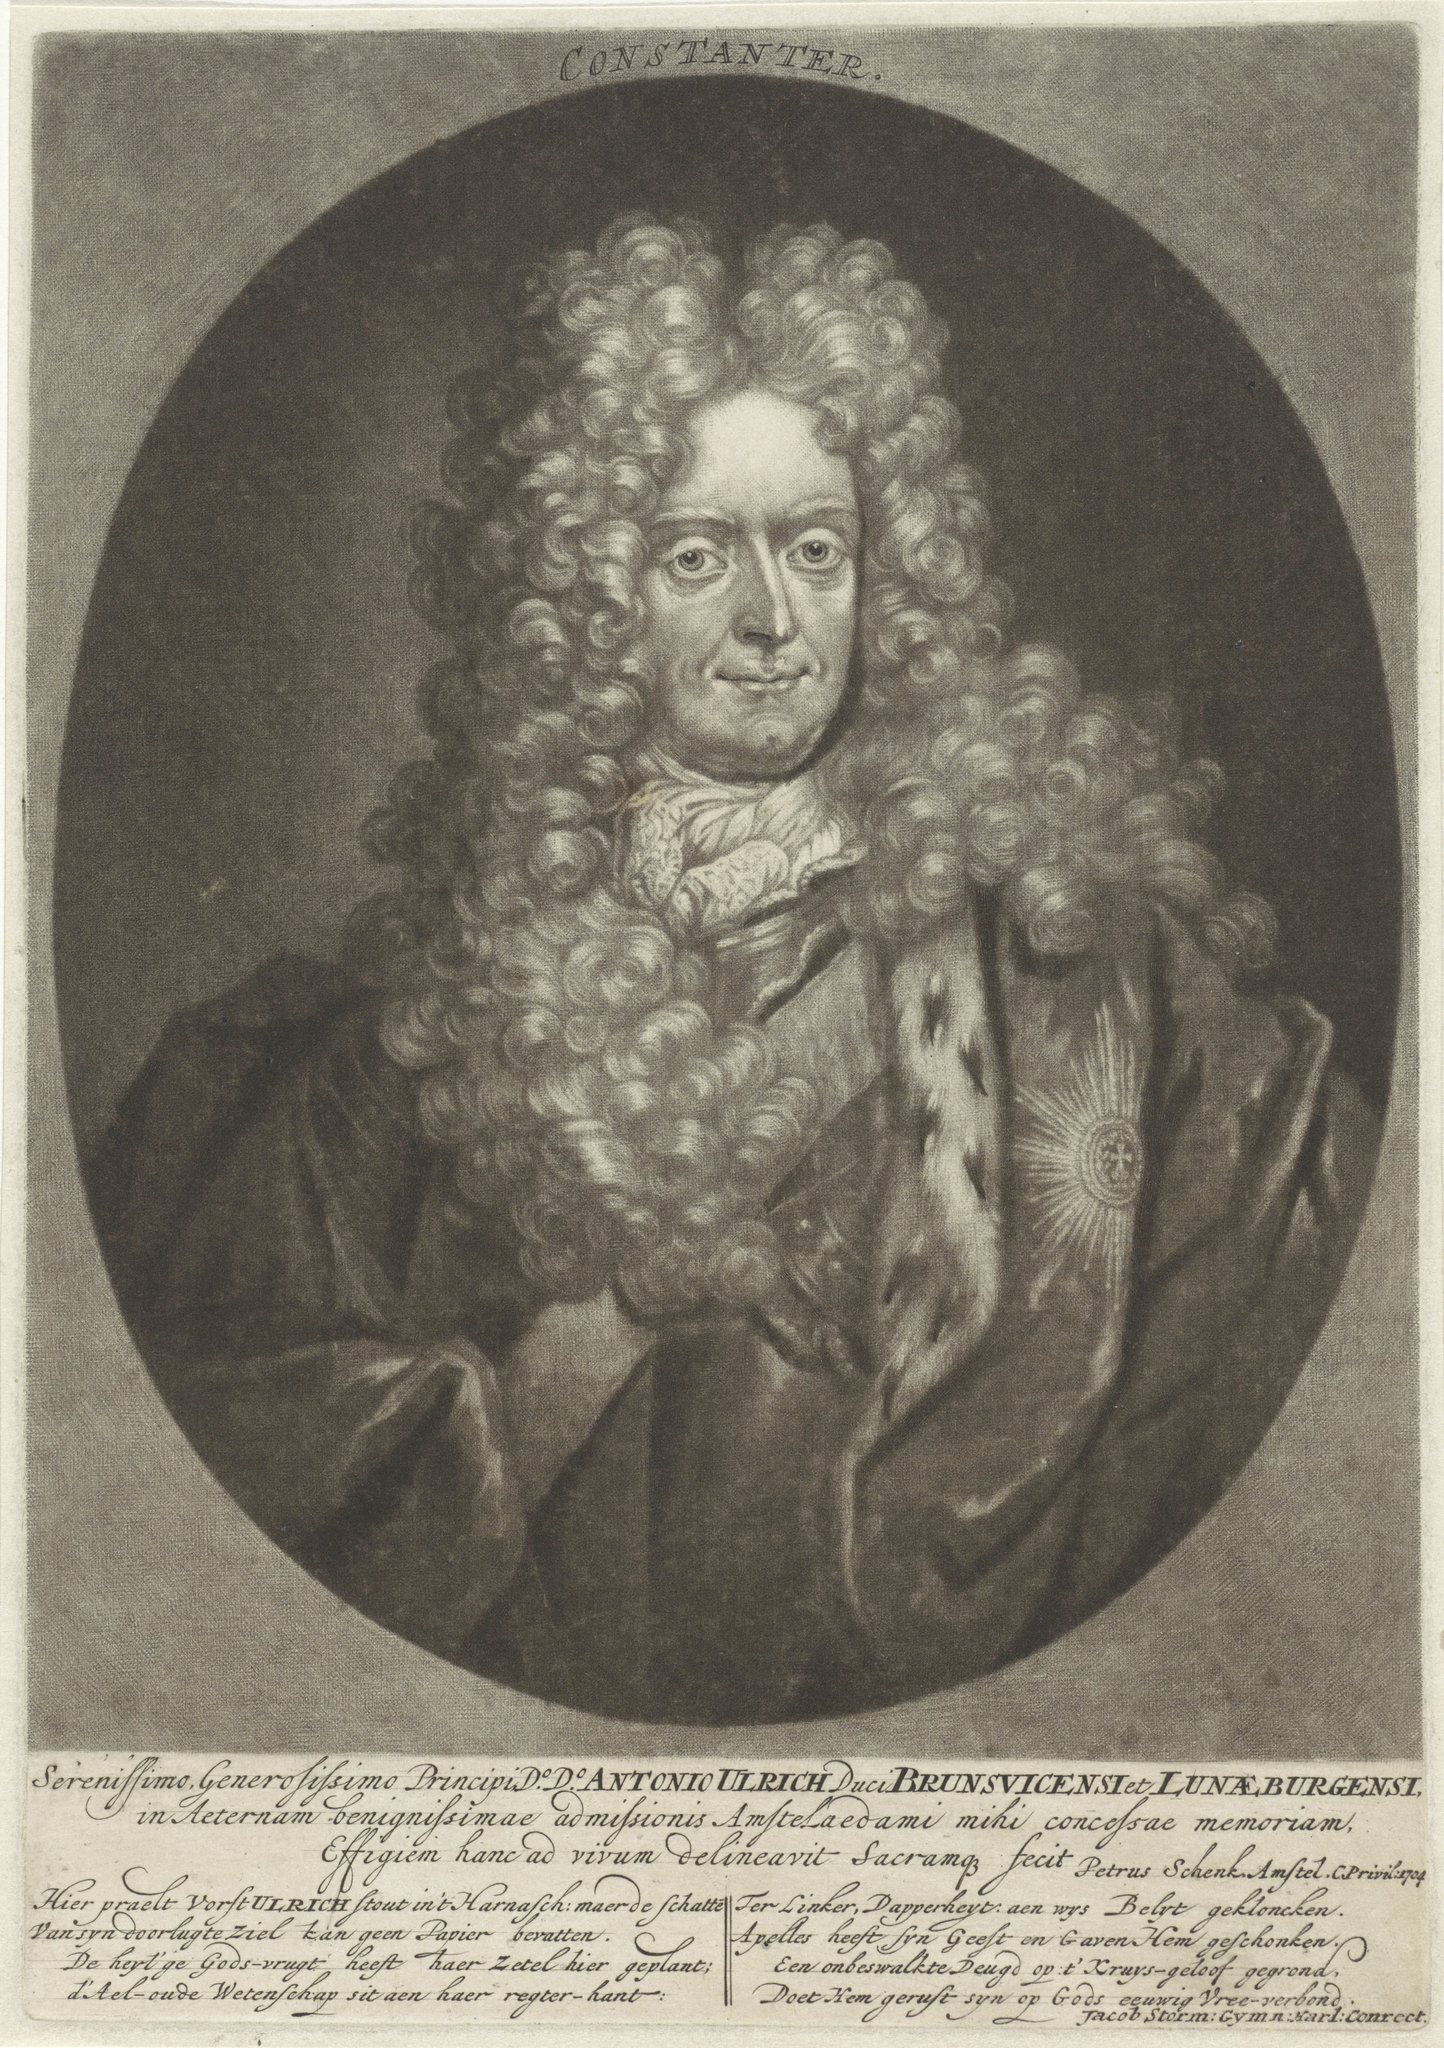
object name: print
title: Portret van Anton Ulrich hertog van Brunswijk-Luneburg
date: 1704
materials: paper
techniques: engraving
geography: amsterdam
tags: wig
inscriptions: collector's mark: Lugt 2228